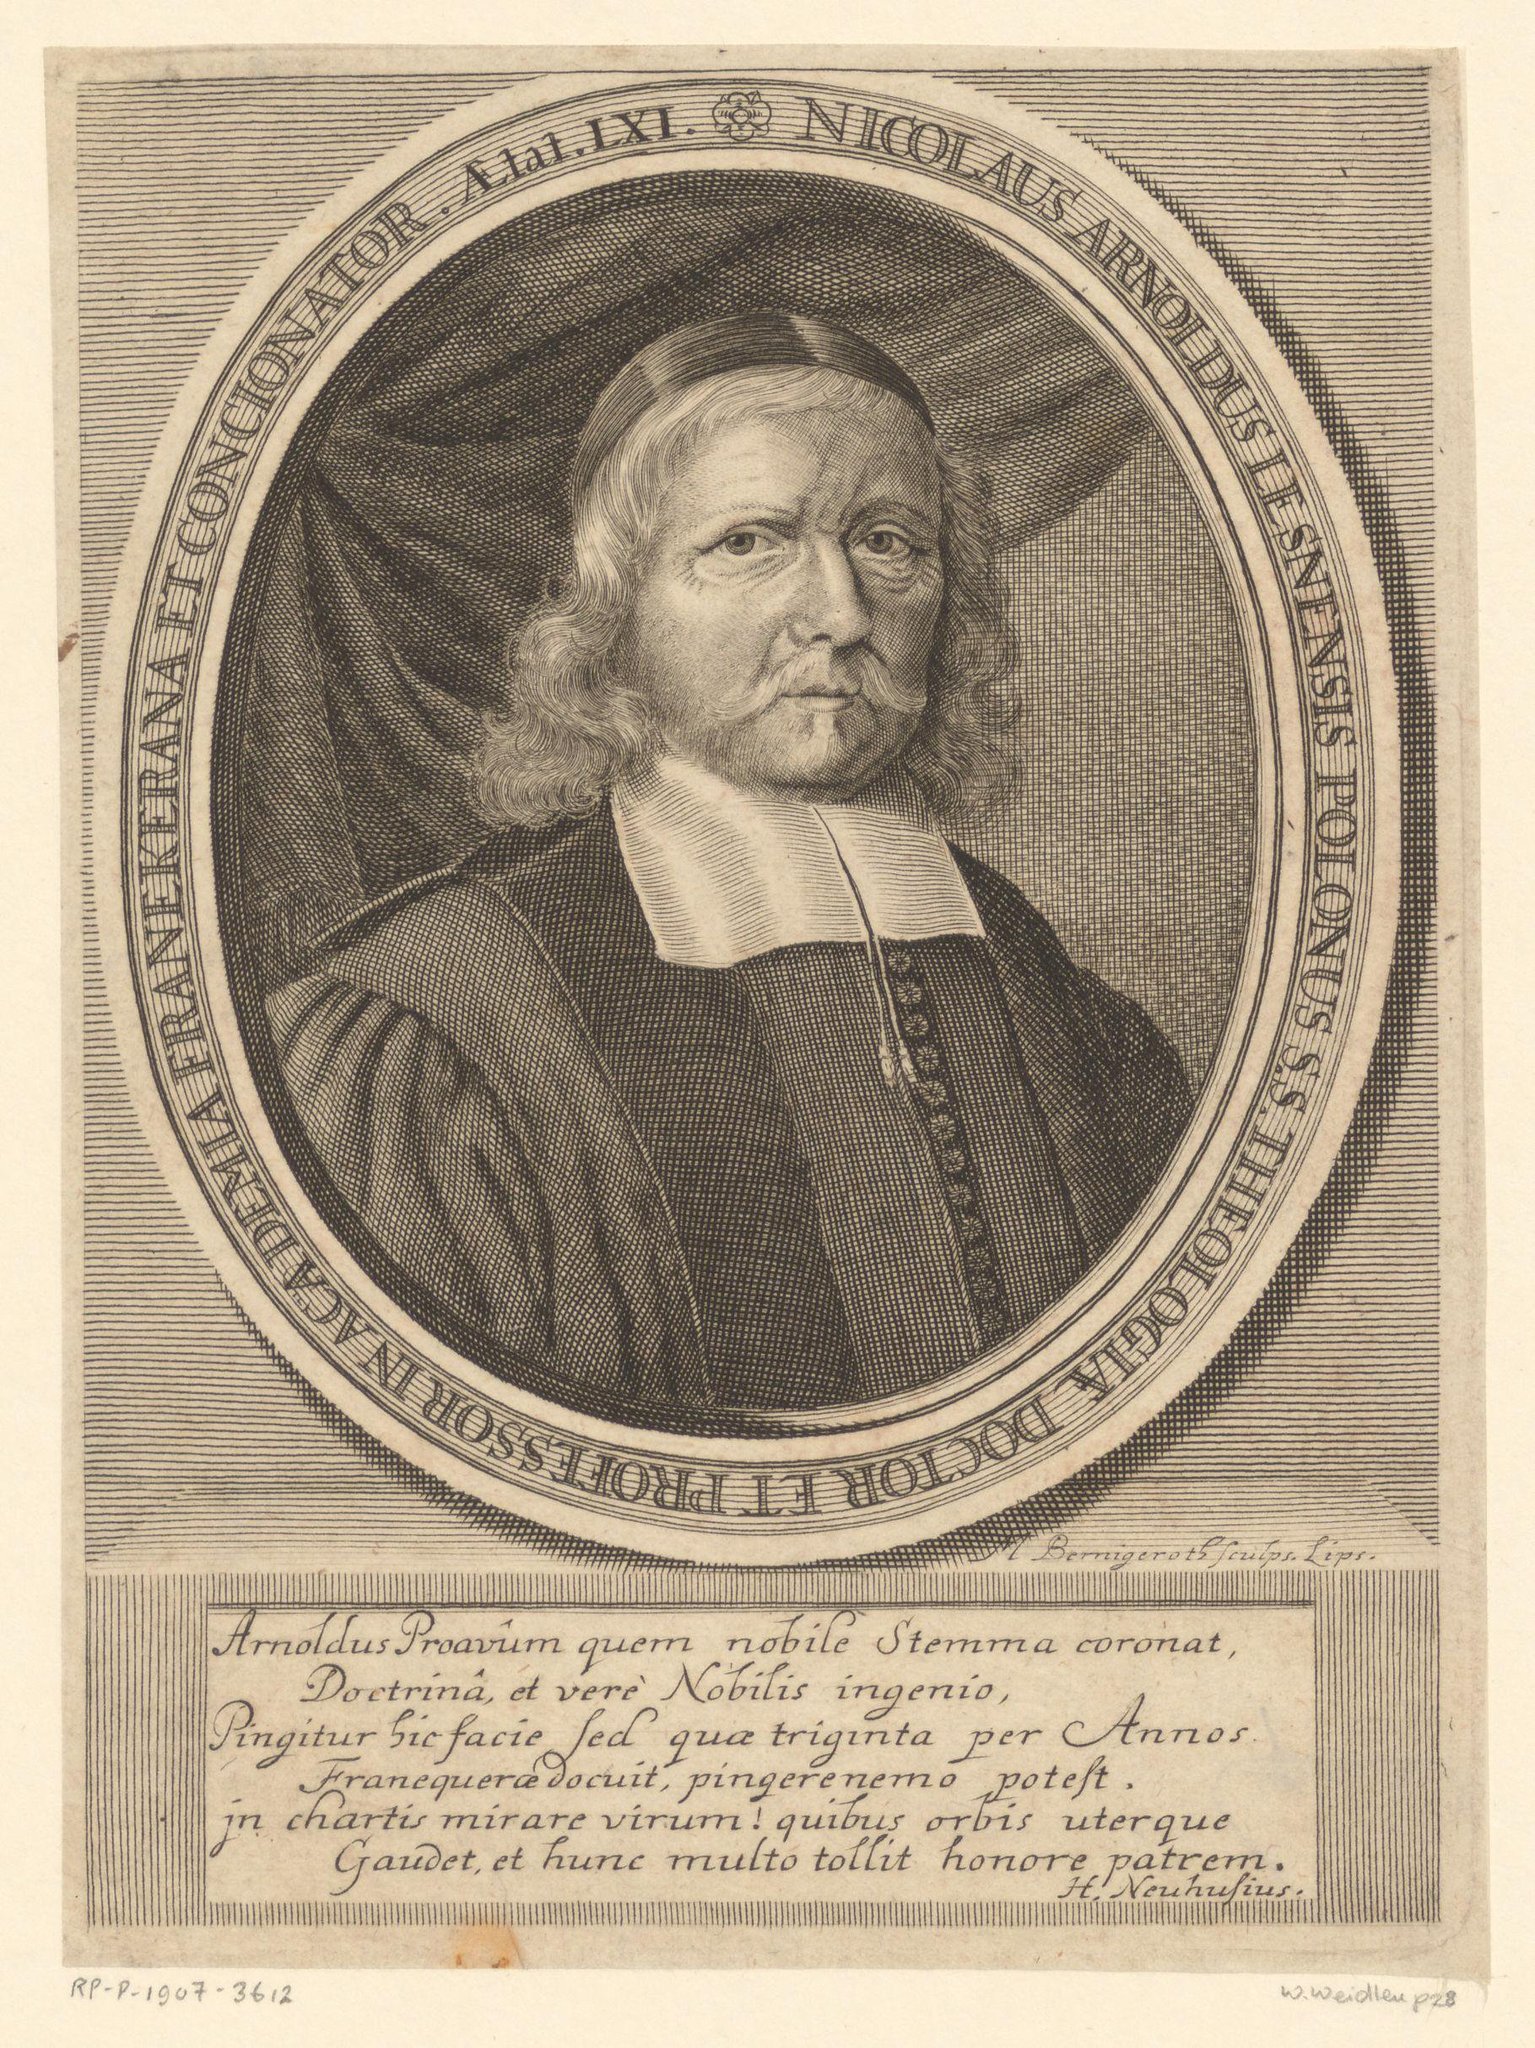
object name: print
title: Portret van Nicolaus Arnoldi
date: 1680-1733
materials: paper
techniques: engraving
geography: leipzig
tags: historical persons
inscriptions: collector's mark: Lugt 2228